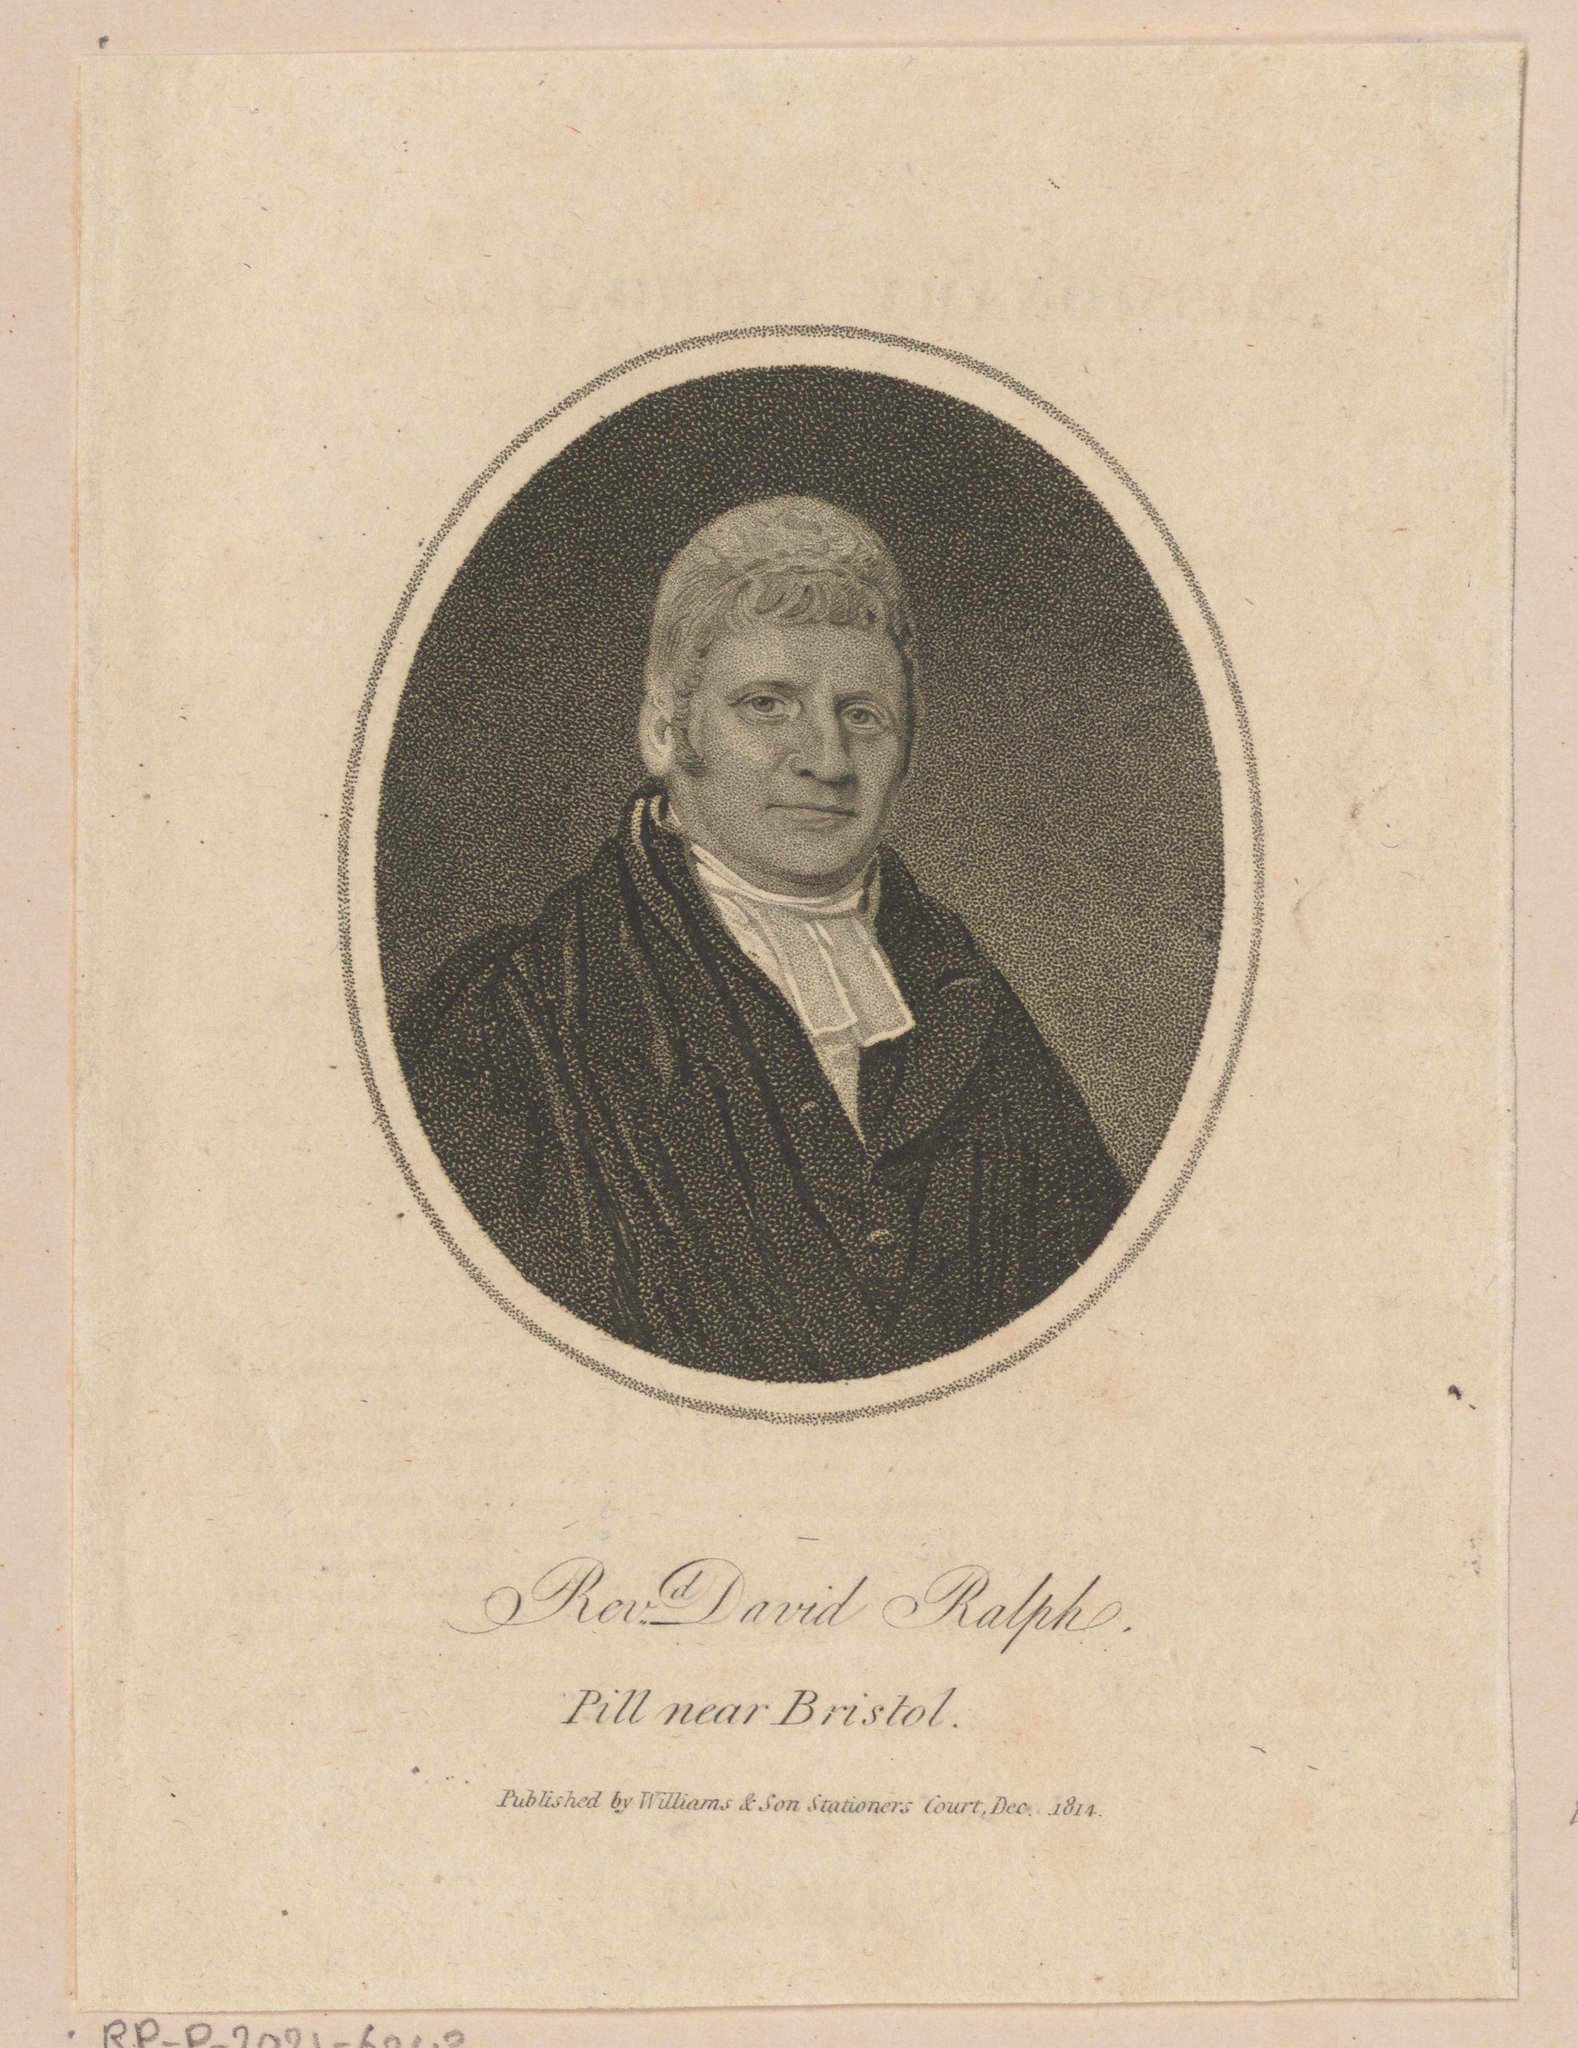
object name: print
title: Portret van David Ralph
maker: Anonymous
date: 1814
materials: paper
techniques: engraving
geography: london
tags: historical persons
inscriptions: date